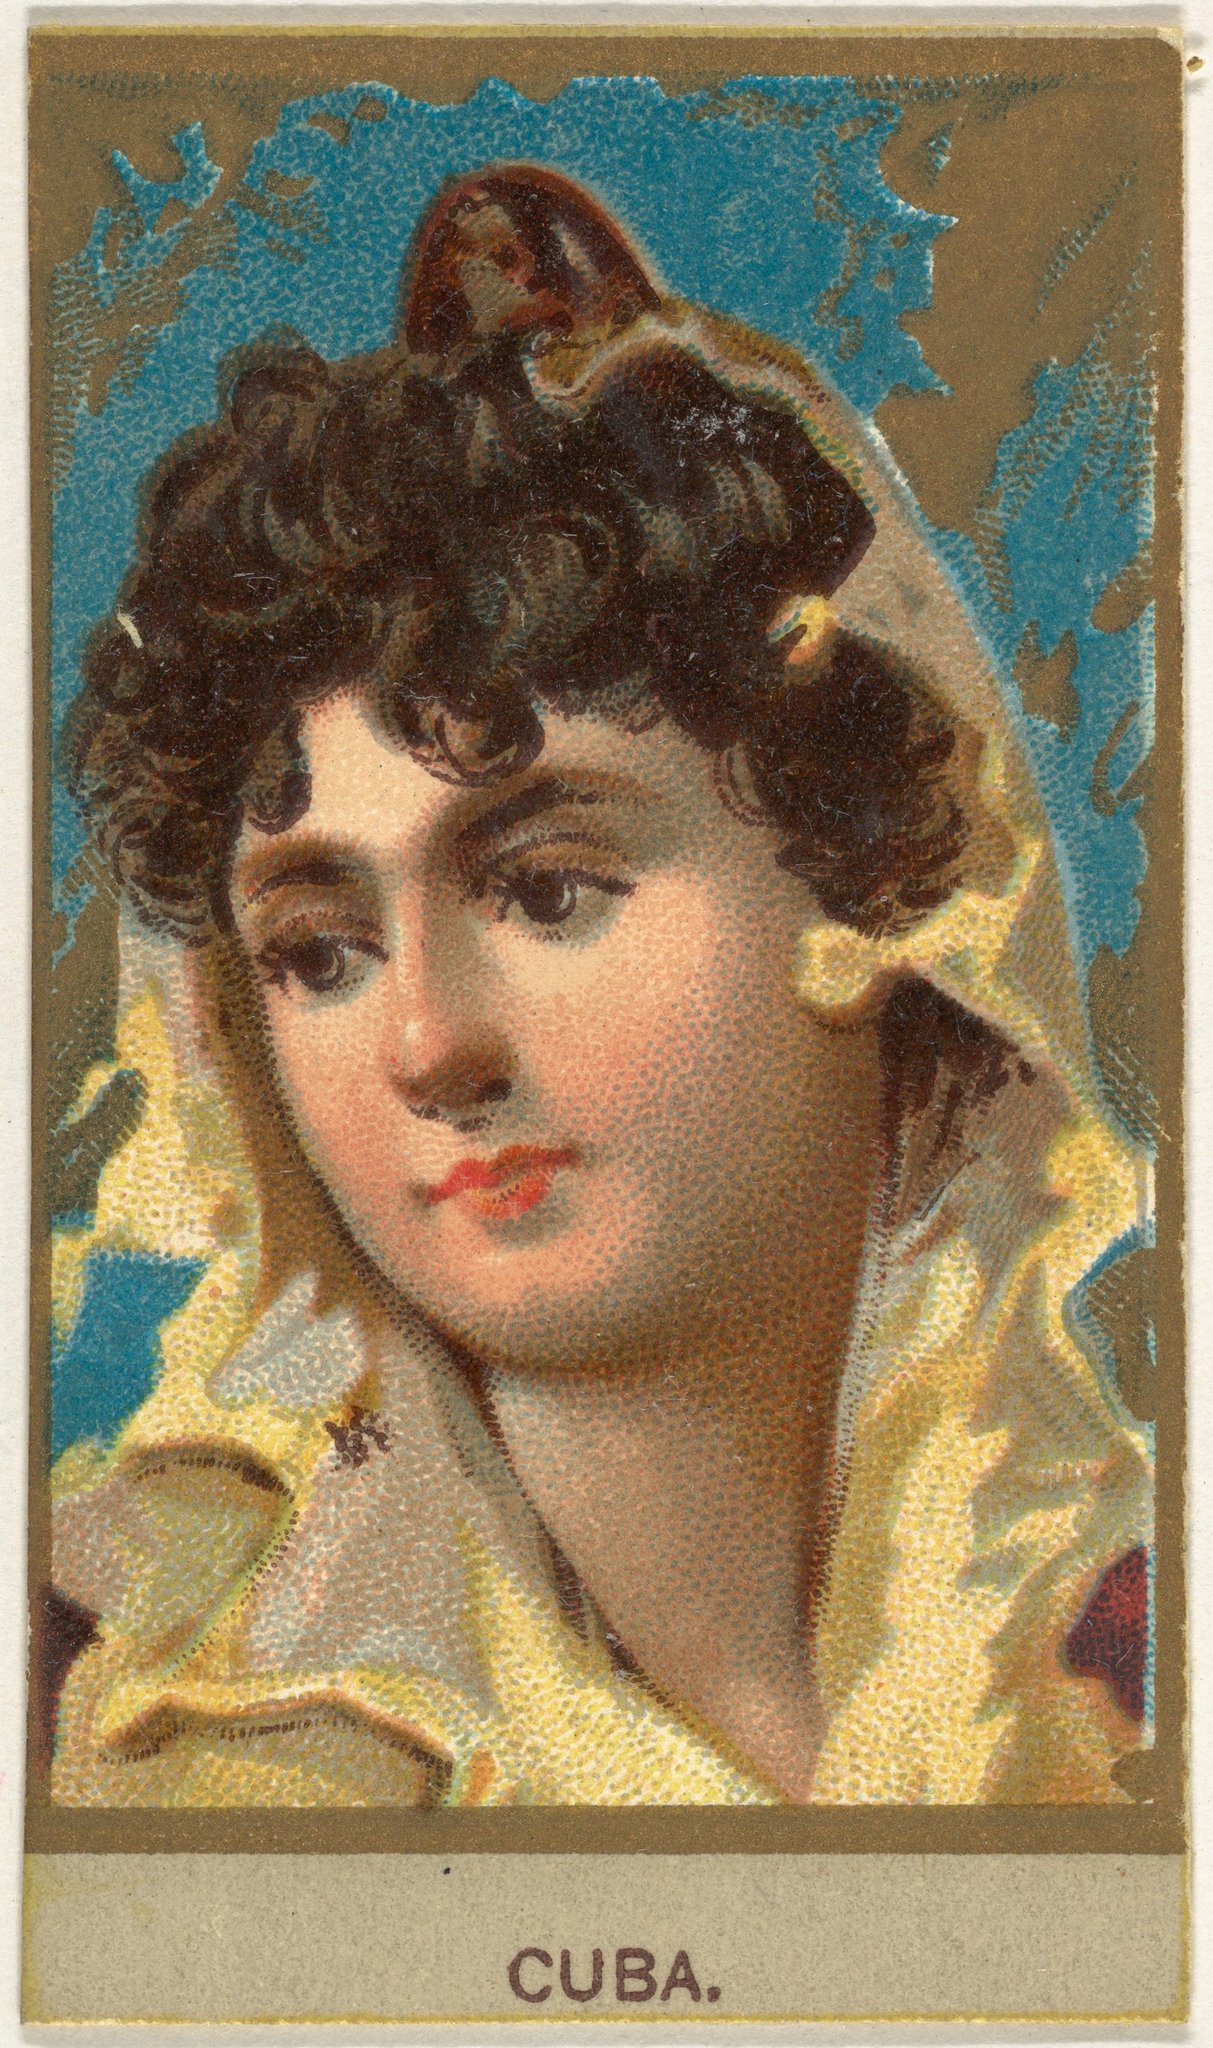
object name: print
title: Cuba, from the Races of Mankind series (T181) issued by Abdul Cigarettes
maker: abdul cigarettes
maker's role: publisher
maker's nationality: american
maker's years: 1881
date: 1881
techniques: color lithograph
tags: women